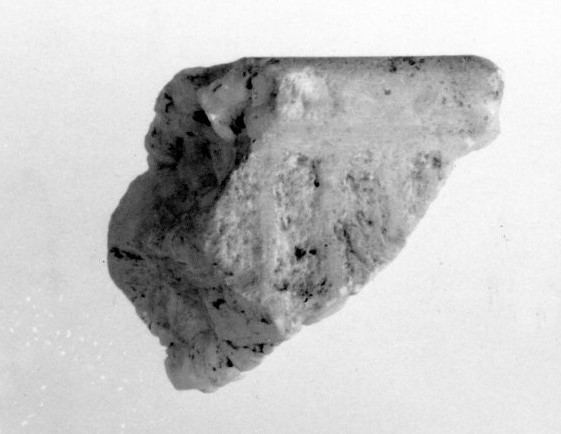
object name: canopic chest fragment, siptah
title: Canopic Chest Lid Fragment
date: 1194-1188 BCE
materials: stone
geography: egypt